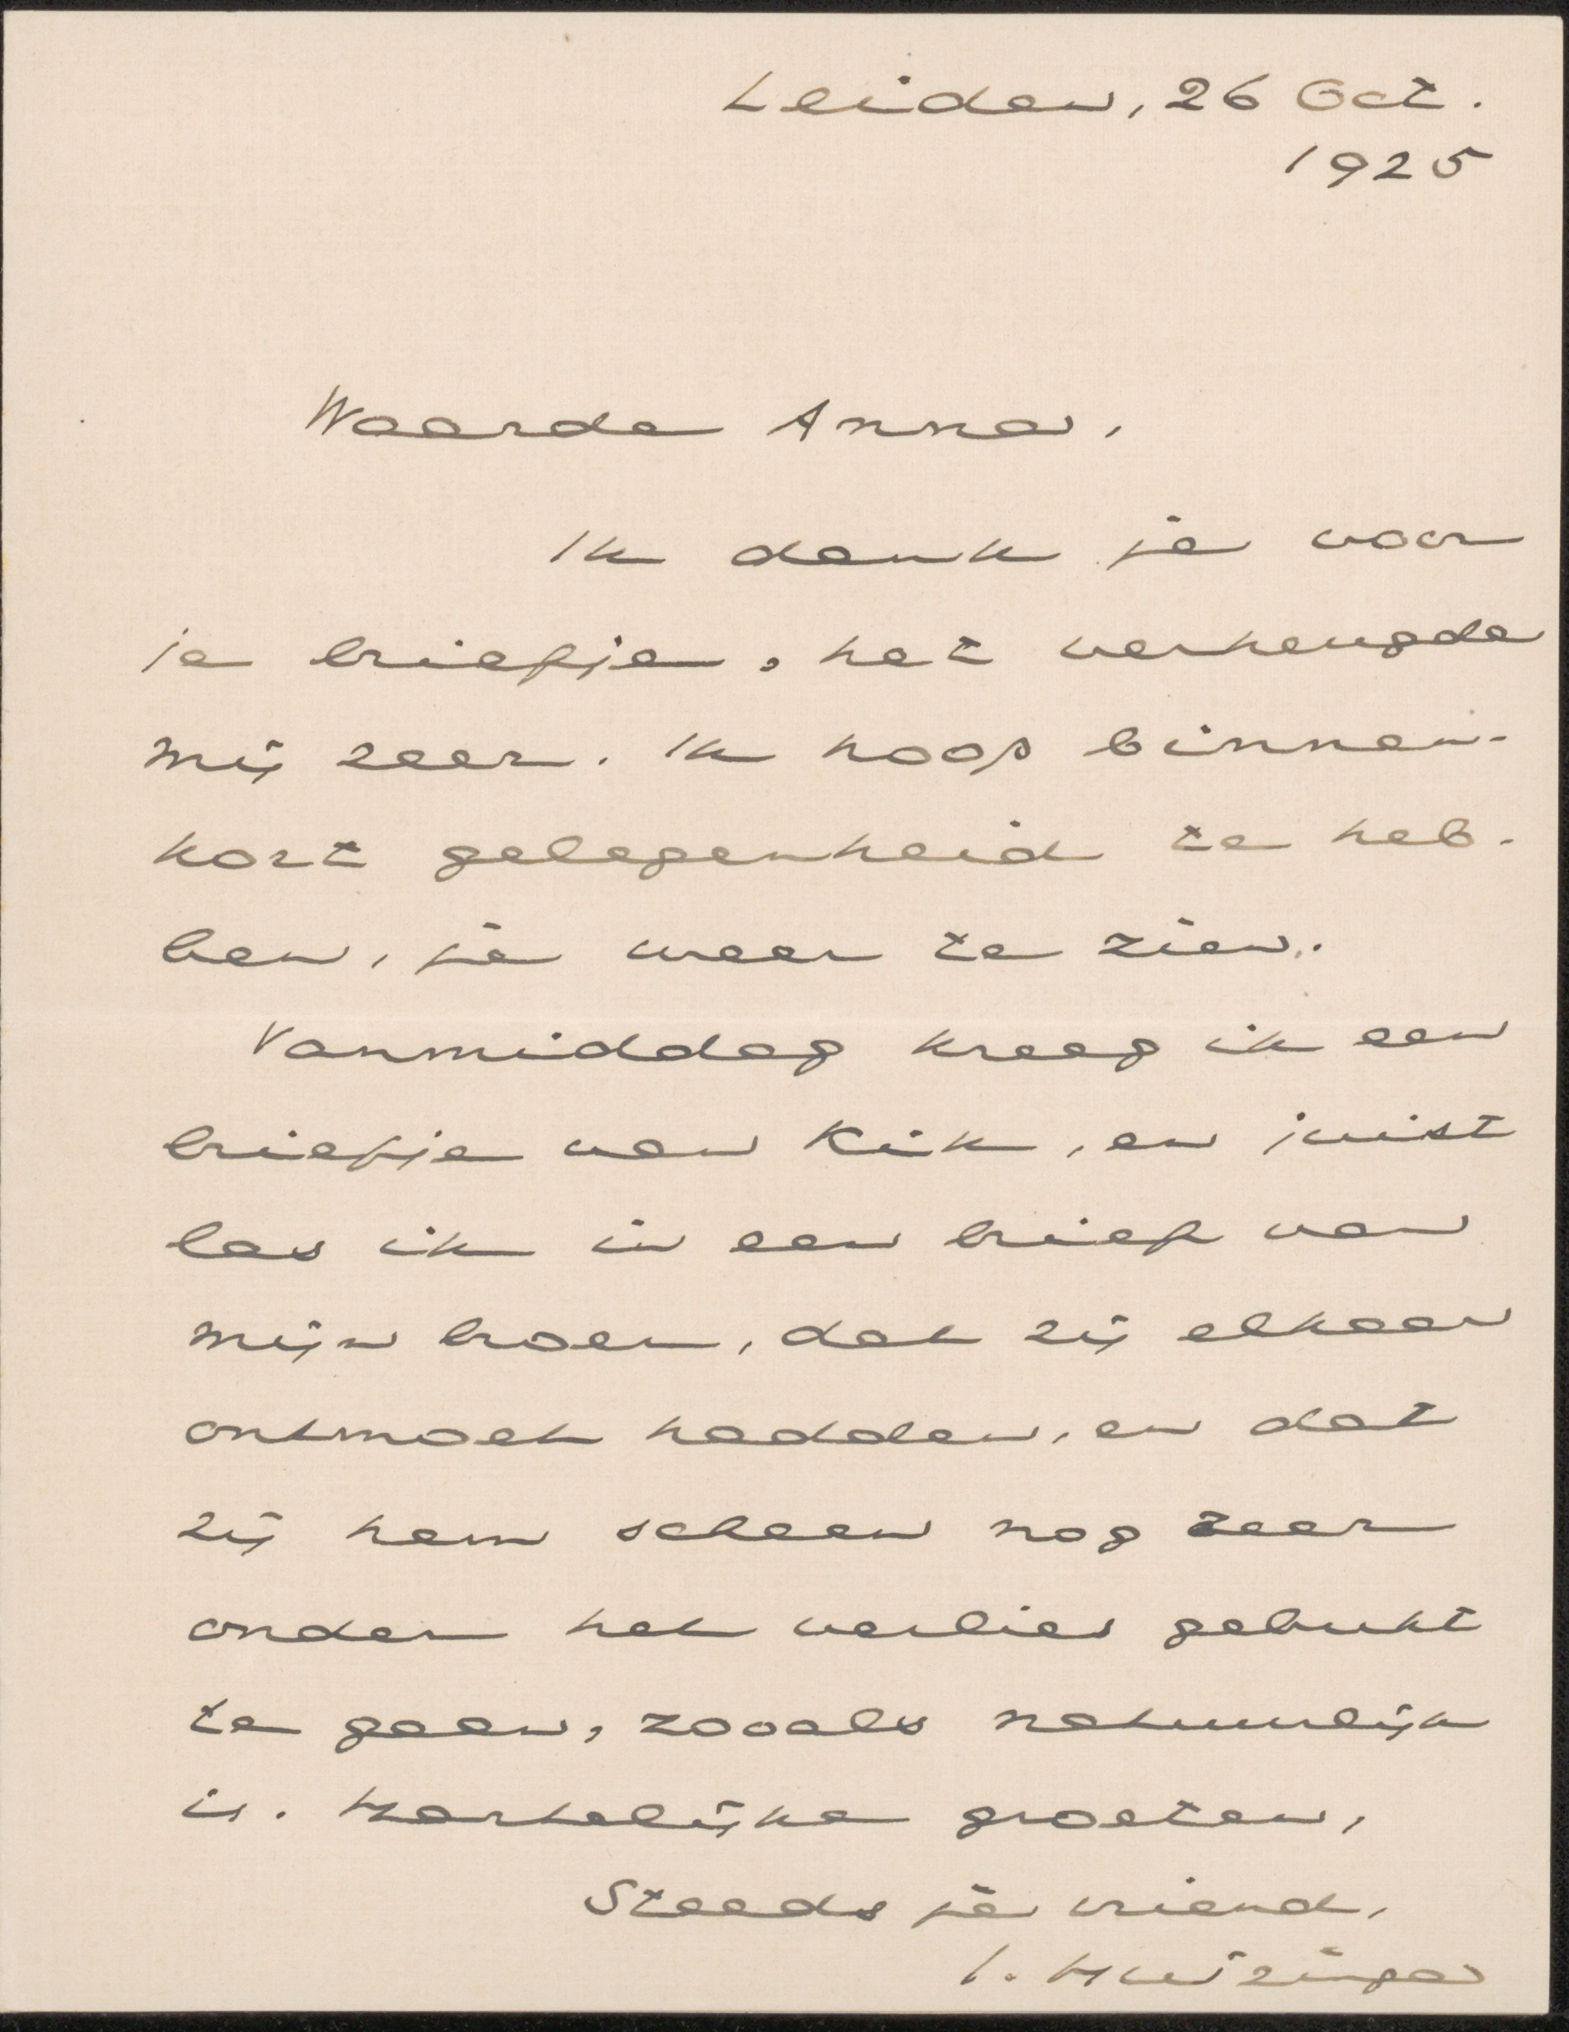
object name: letter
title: Brief aan Anna Dorothea Dirks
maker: johan huizinga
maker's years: 1872-1945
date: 1925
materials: ink, paper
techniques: pen, writing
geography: leiden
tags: artist, anna dorothea dirks, family life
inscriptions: collector's mark: ‘RPK’